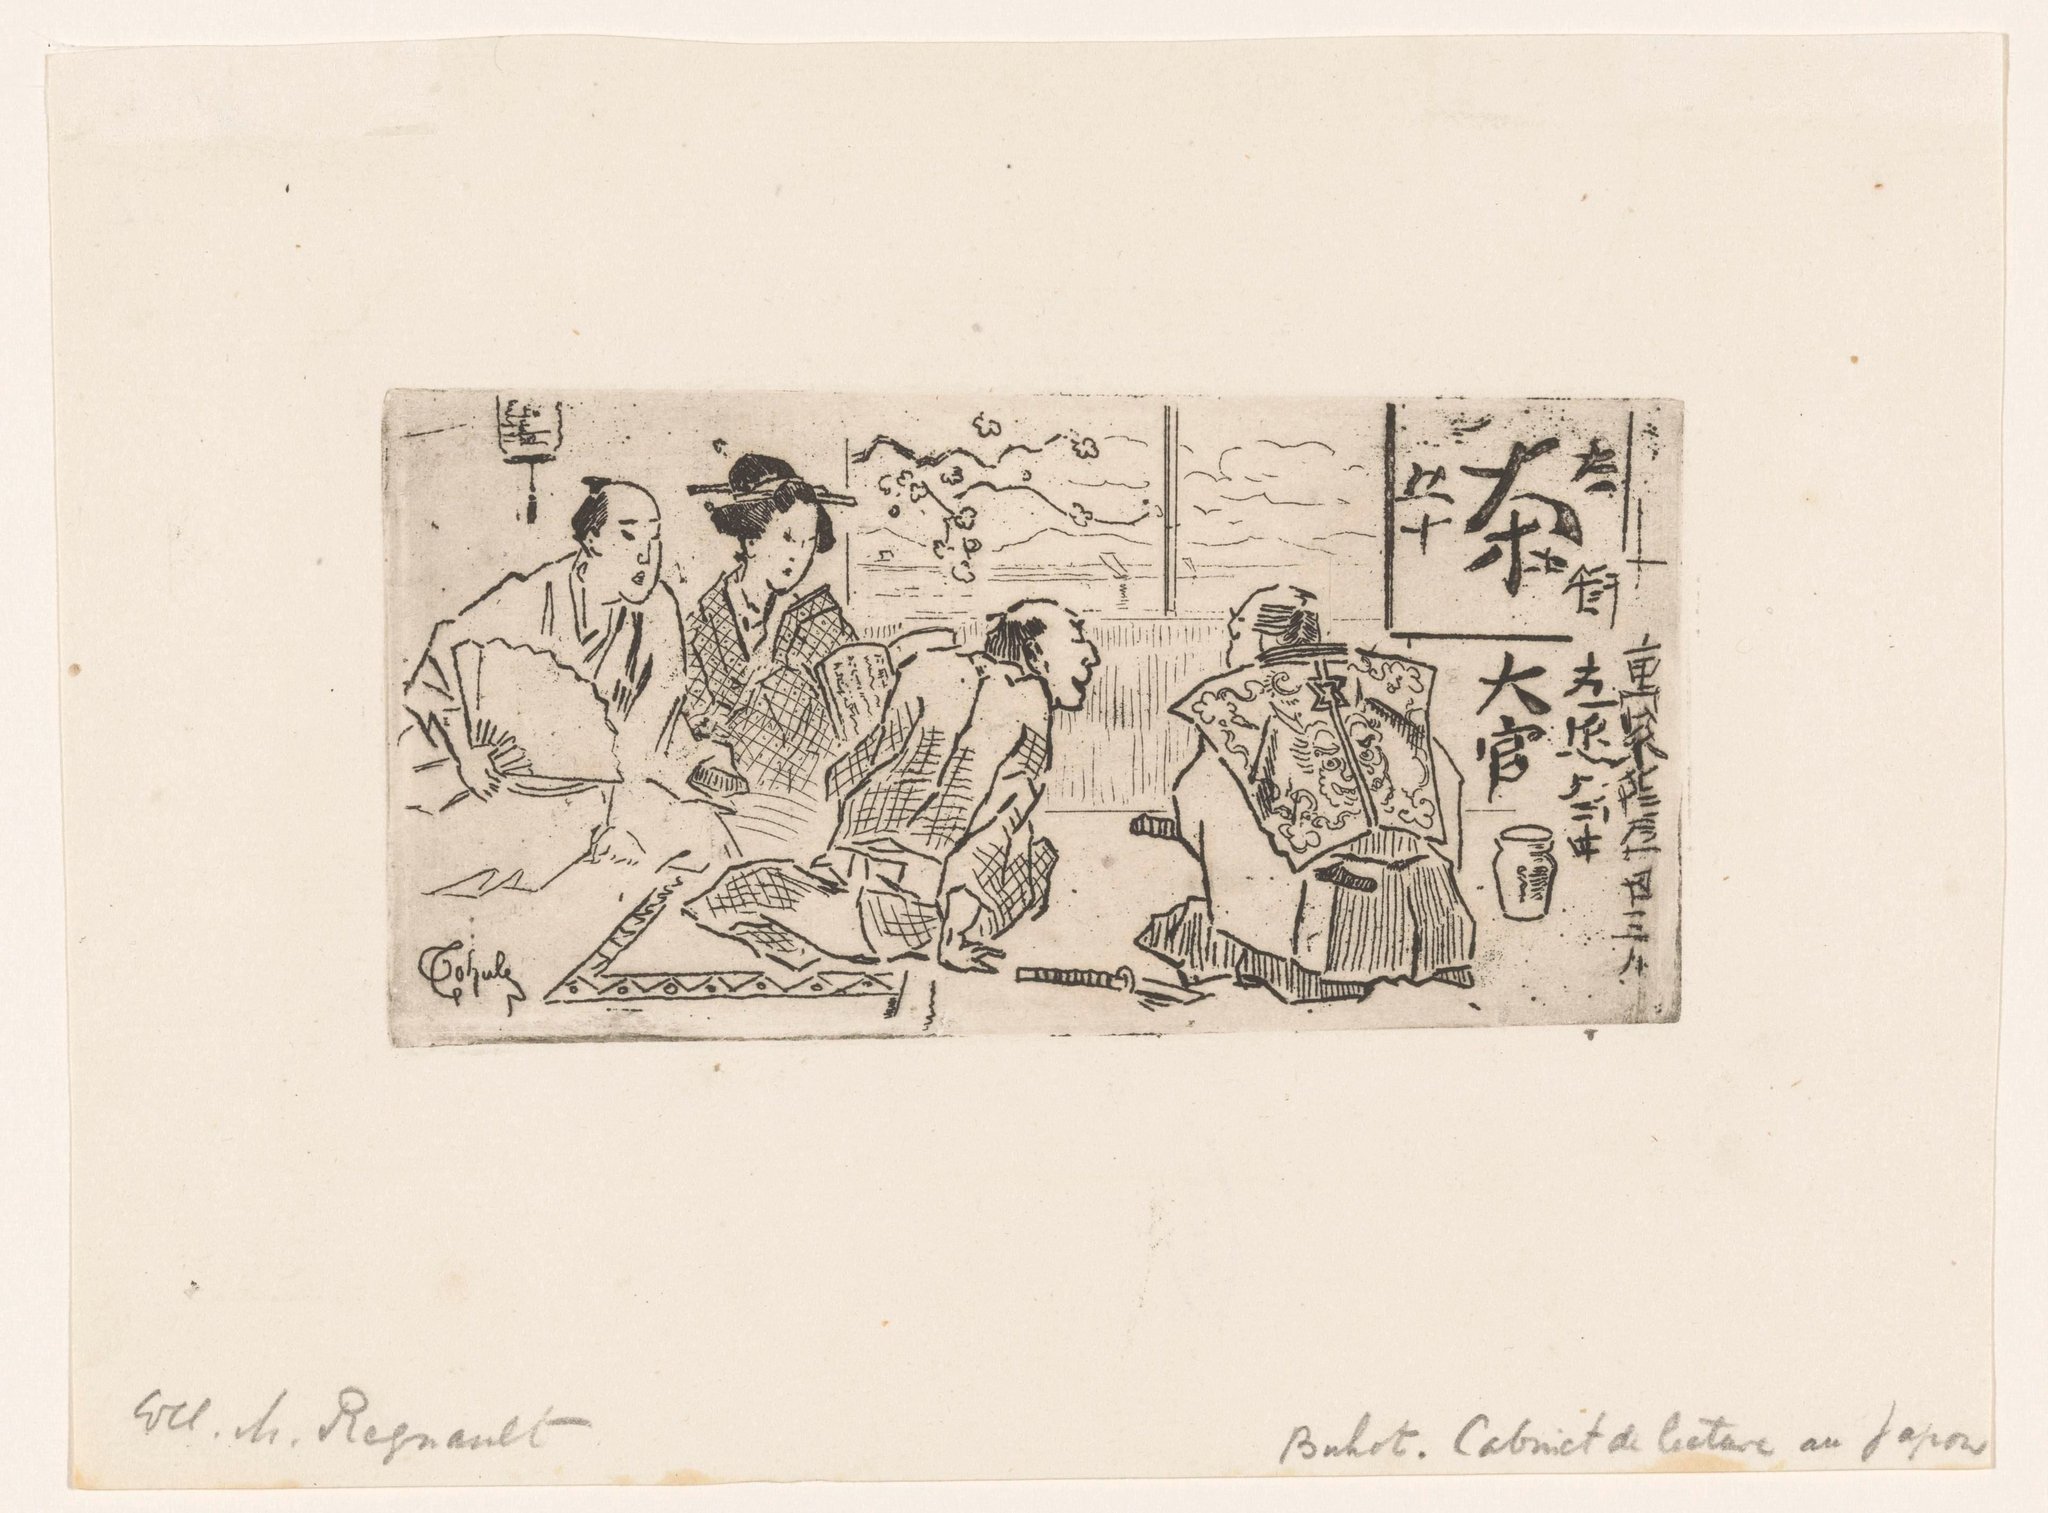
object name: print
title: Cabinet de lecture au Japon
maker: félix hilaire buhot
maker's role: draughtsman, print maker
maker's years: 1847-1898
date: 1873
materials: paper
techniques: etching, intaglio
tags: japanese, public library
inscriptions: annotation: ‘coll. [?] h. Regnault/ Buhot. Cabinet de lecture au Japon’, collector's mark: Lugt 2228